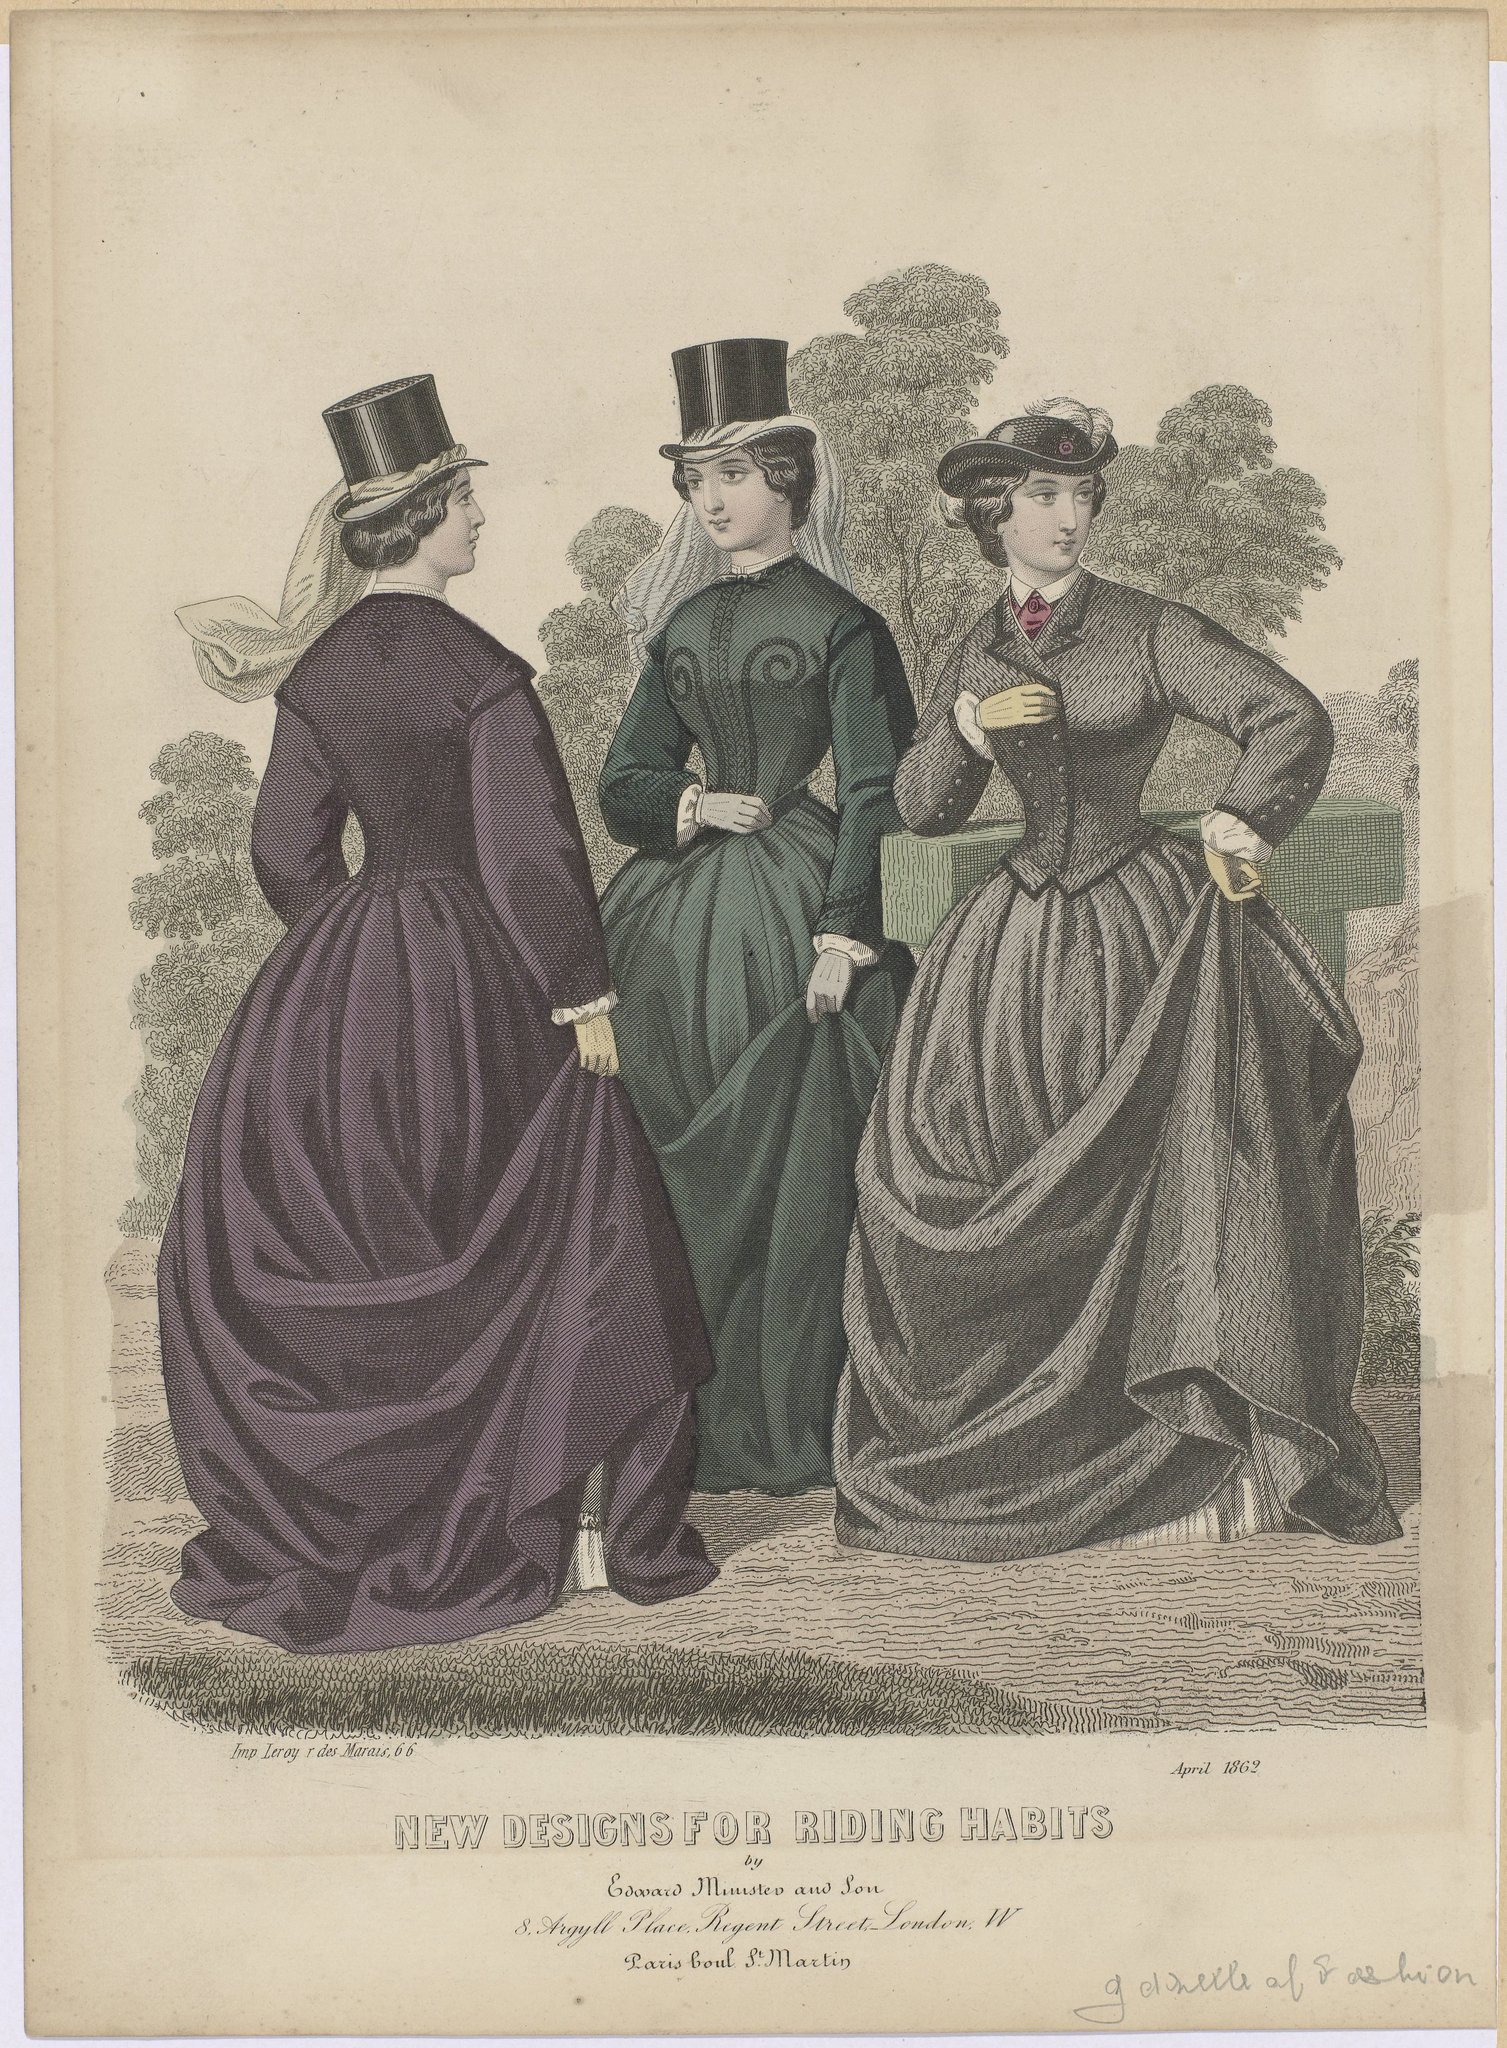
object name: fashion print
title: Gazette of Fashion, New designs for riding habits, April 1862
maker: Anonymous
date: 1862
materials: paper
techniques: engraving, hand coloring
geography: paris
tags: riding a horse, ass, or mule; rider, horseman, veil (+ women's clothes), underclothes for the lower part of the body (underskirt) (+ women's clothes), coat (+ women's clothes), fashion plates, head-gear: hat (+ women's clothes), skirt (+ women's clothes), ensembles of pieces of clothing (riding costume) (+ women's clothes)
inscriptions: title: ‘NEW DESIGNS FOR RIDING HABITS by Edward Minister and Son’, address: ‘8, Argyll Place Regent Street London. W / Paris, boul. S.t Martin’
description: Drie vrouwen in de nieuwste ontwerpen voor amazonekostuums of rijkostuums in april 1862. Twee dragen een hoge hoed met sluier. De ander een lage bolhoed met opstaande randen, versierd met kokarde(?) en struisveer. Prent uit het modetijdschrift The Gazette of Fashion, and Cutting-Room Compagnion (1847-19..?).